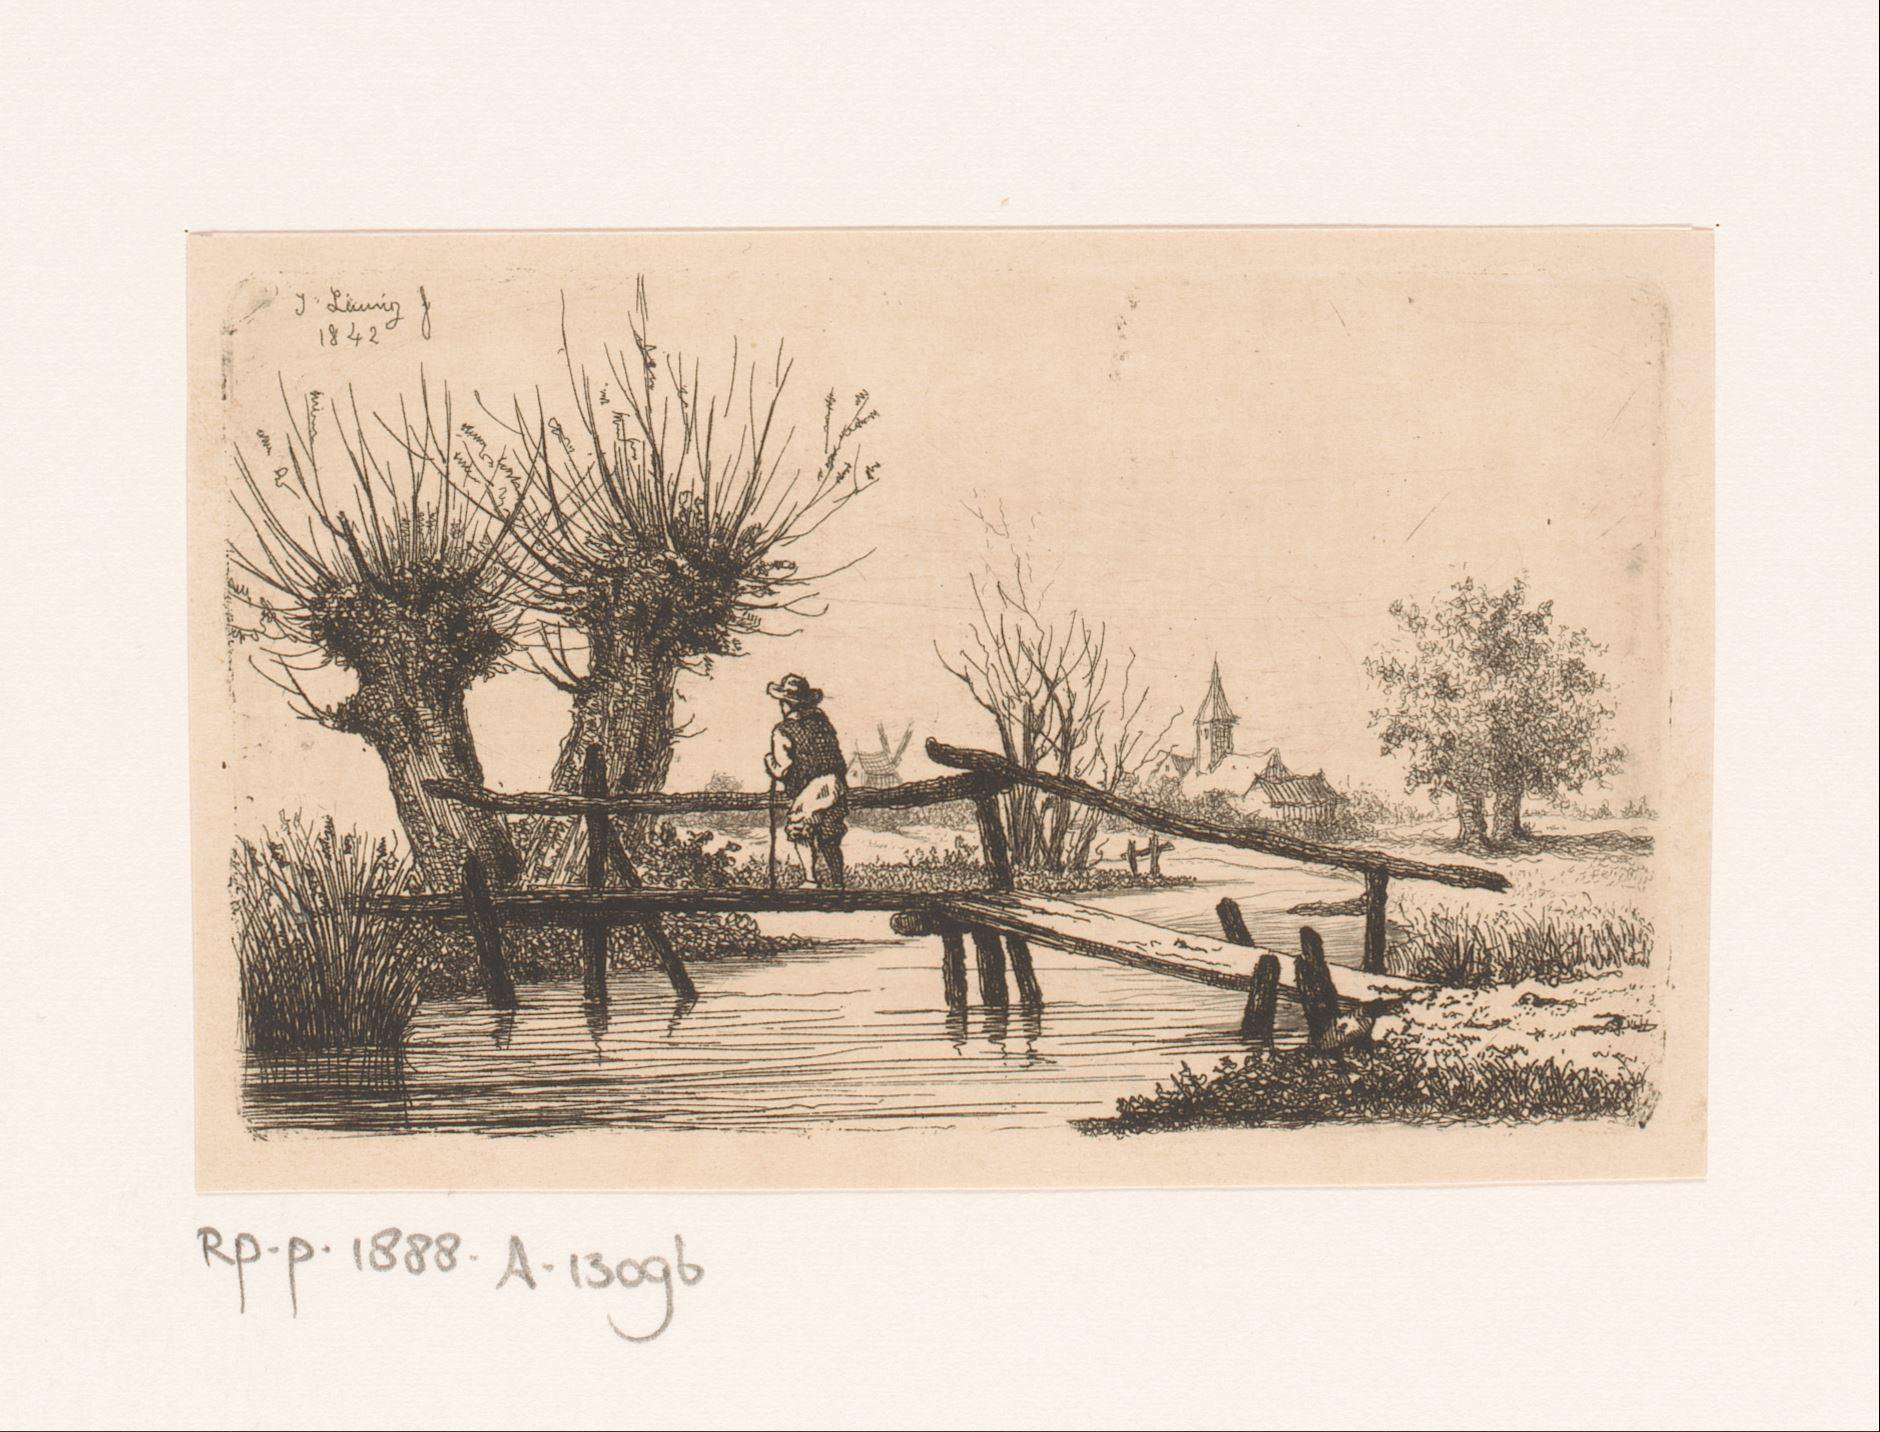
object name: print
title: Houten brug in Oosterweel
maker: jean théodore joseph linnig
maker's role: draughtsman, print maker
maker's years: 1815-1891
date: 1842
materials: paper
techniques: etching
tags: landscape with bridge, viaduct or aqueduct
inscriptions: collector's mark: Lugt 2228